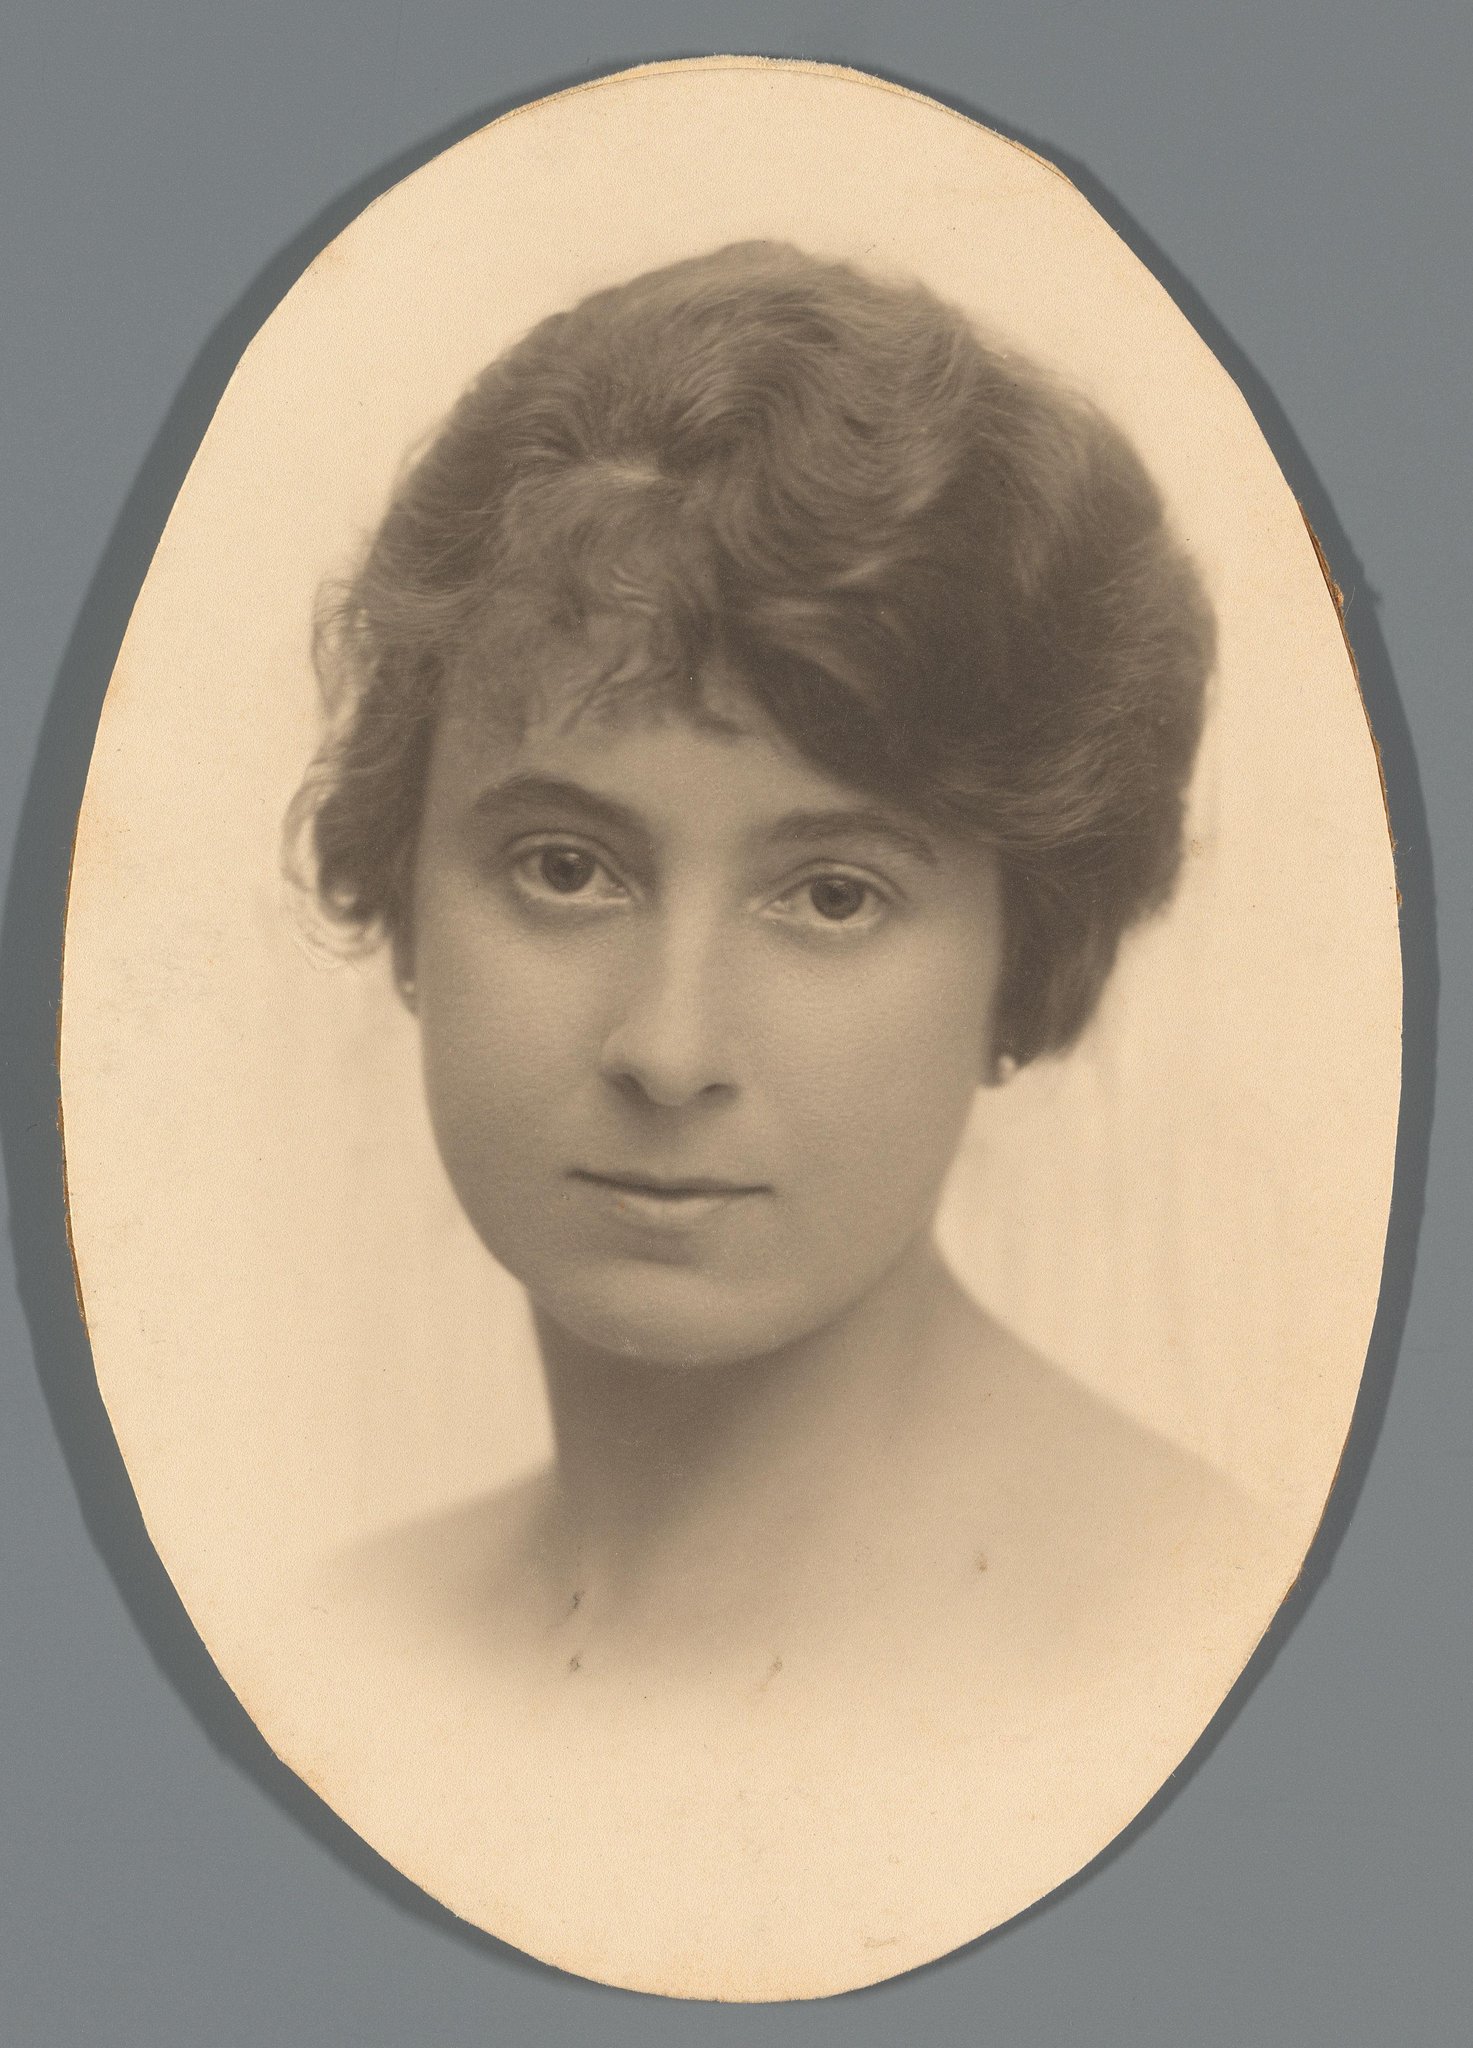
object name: photograph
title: Portret van Corrie van den Berg-Knottenbelt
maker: Anonymous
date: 1906-1921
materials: cardboard, photographic support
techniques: albumen print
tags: corrie van den berg-knottenbelt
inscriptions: inscription: ‘Corry . Juni 1921.’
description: Ovaal uitgeknipt portret van jonge vrouw.